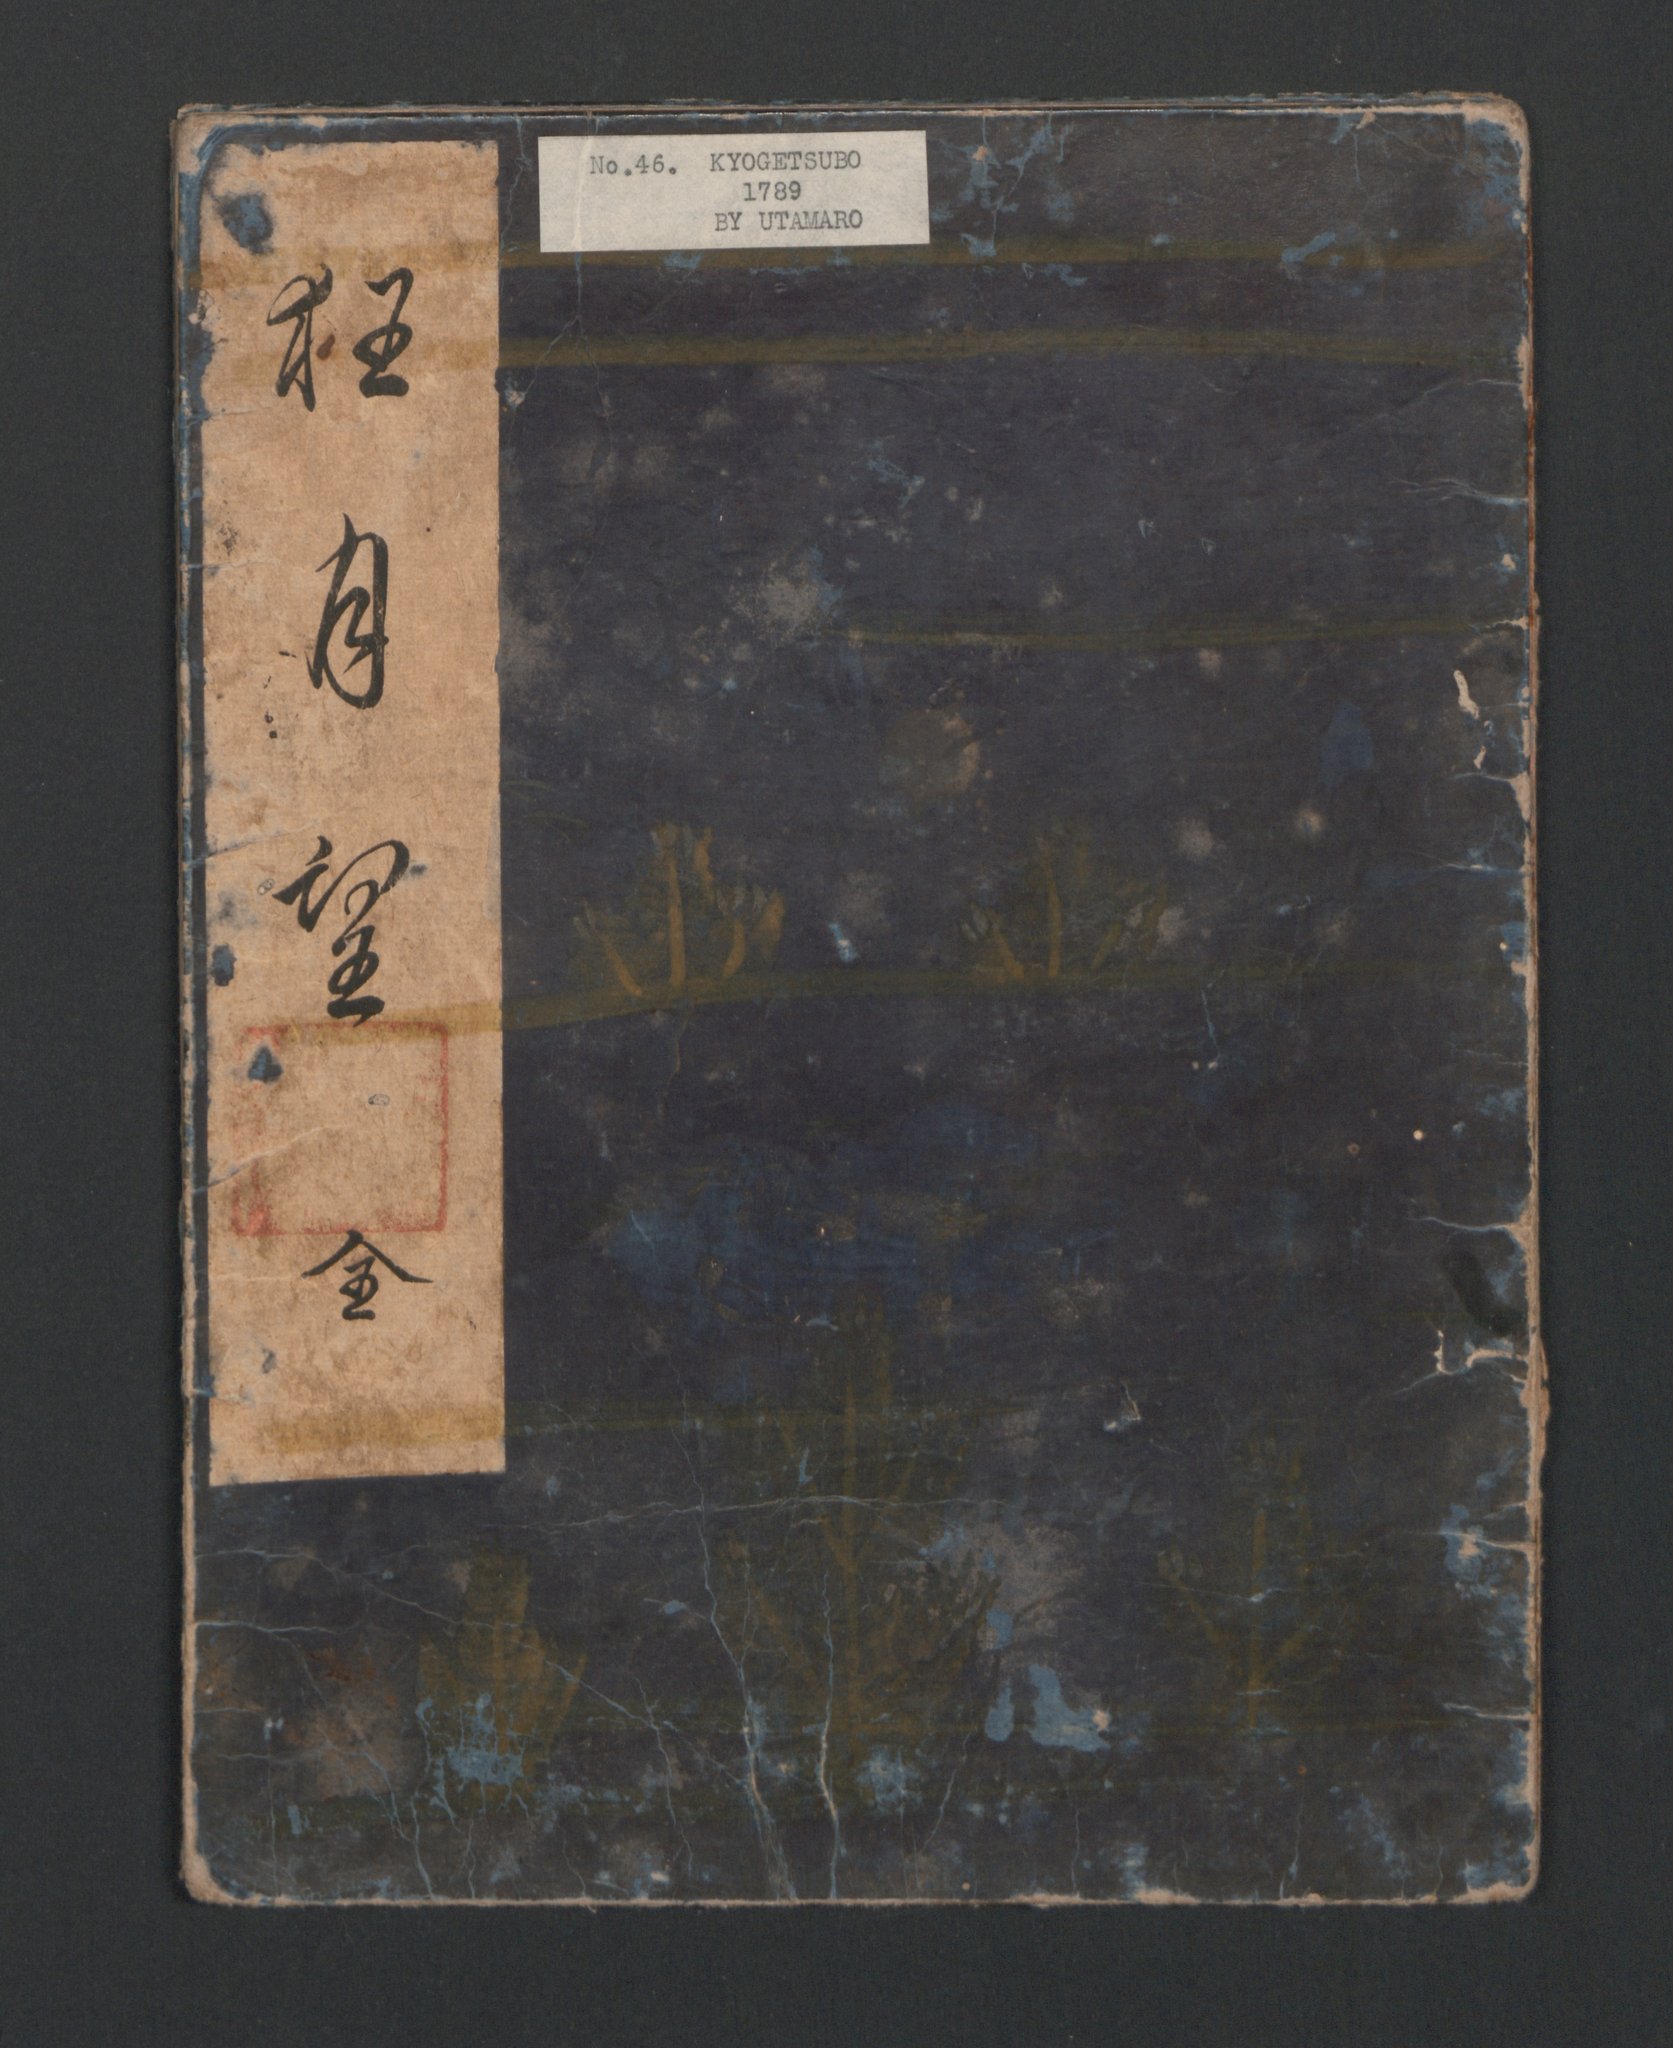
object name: illustrated book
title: The Moon-Mad Monk, or Crazy Gazing at the Moon (Kyōgetsubō 狂月坊)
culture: japanese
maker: kitagawa utamaro 喜多川歌麿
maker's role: artist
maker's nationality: japanese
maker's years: 1754-1806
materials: ink, paper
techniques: polychrome, woodblock print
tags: moon,trees,monks